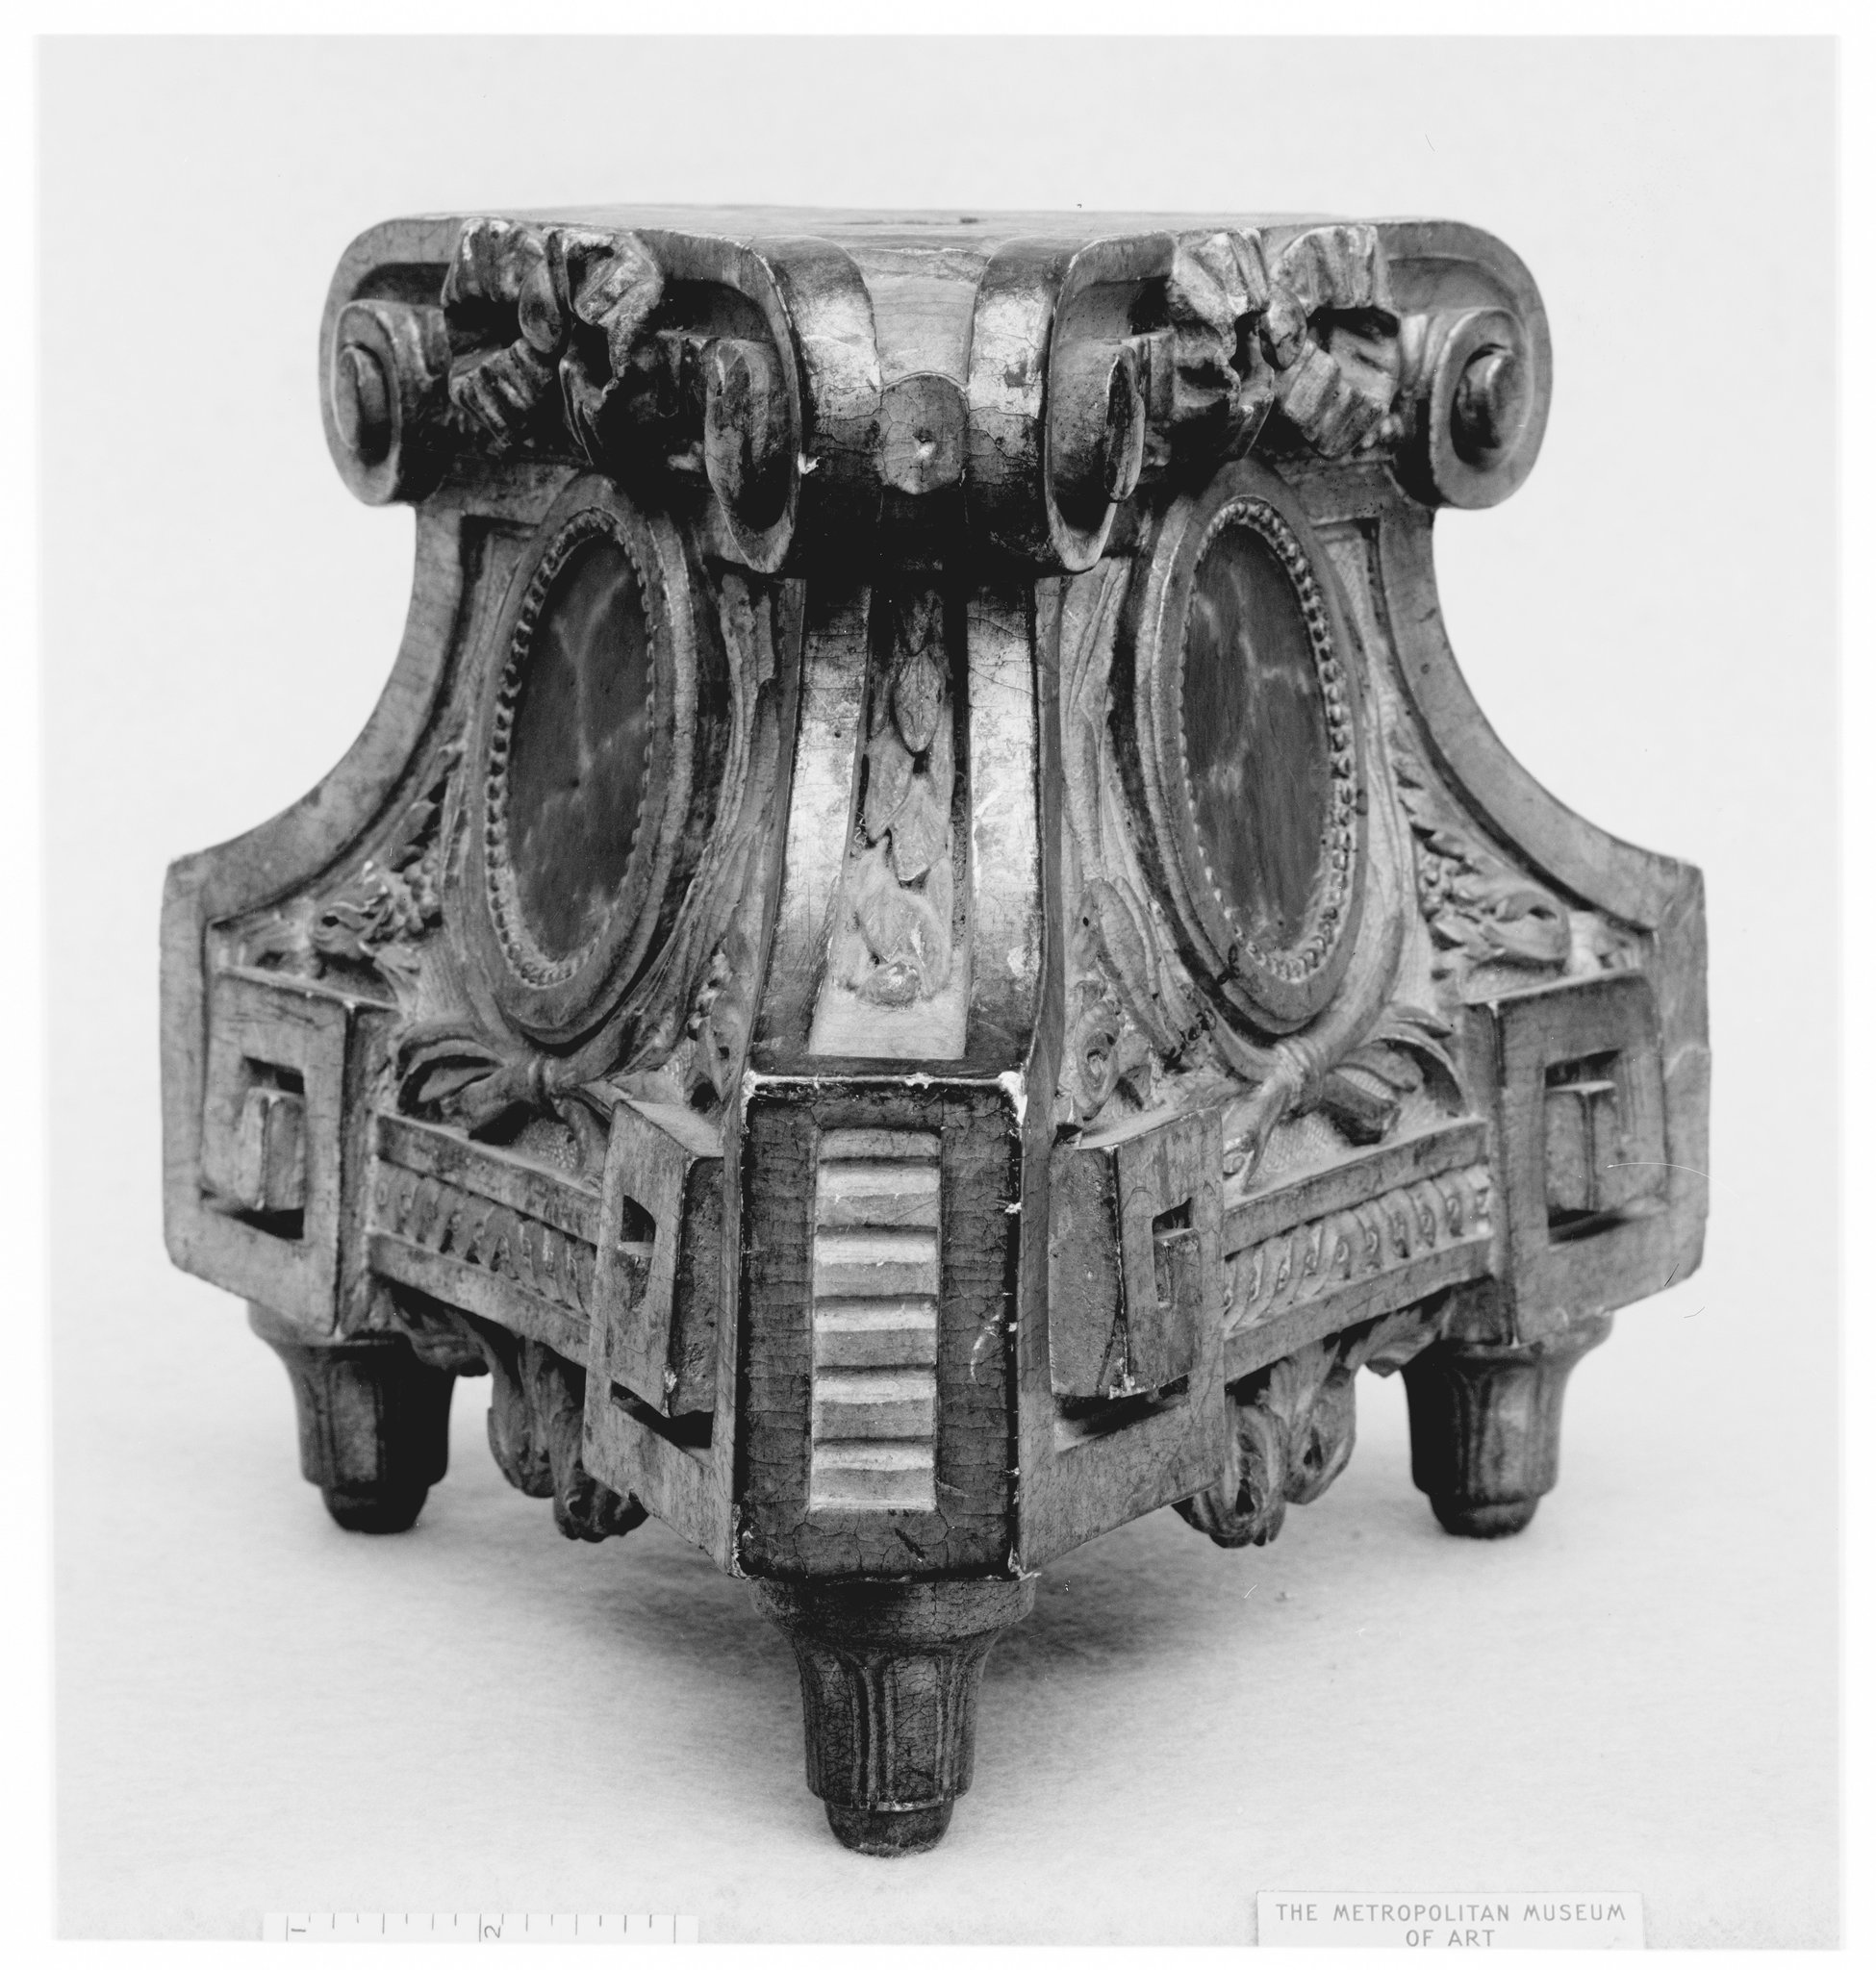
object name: pedestal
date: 1751-1775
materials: gilt, wood